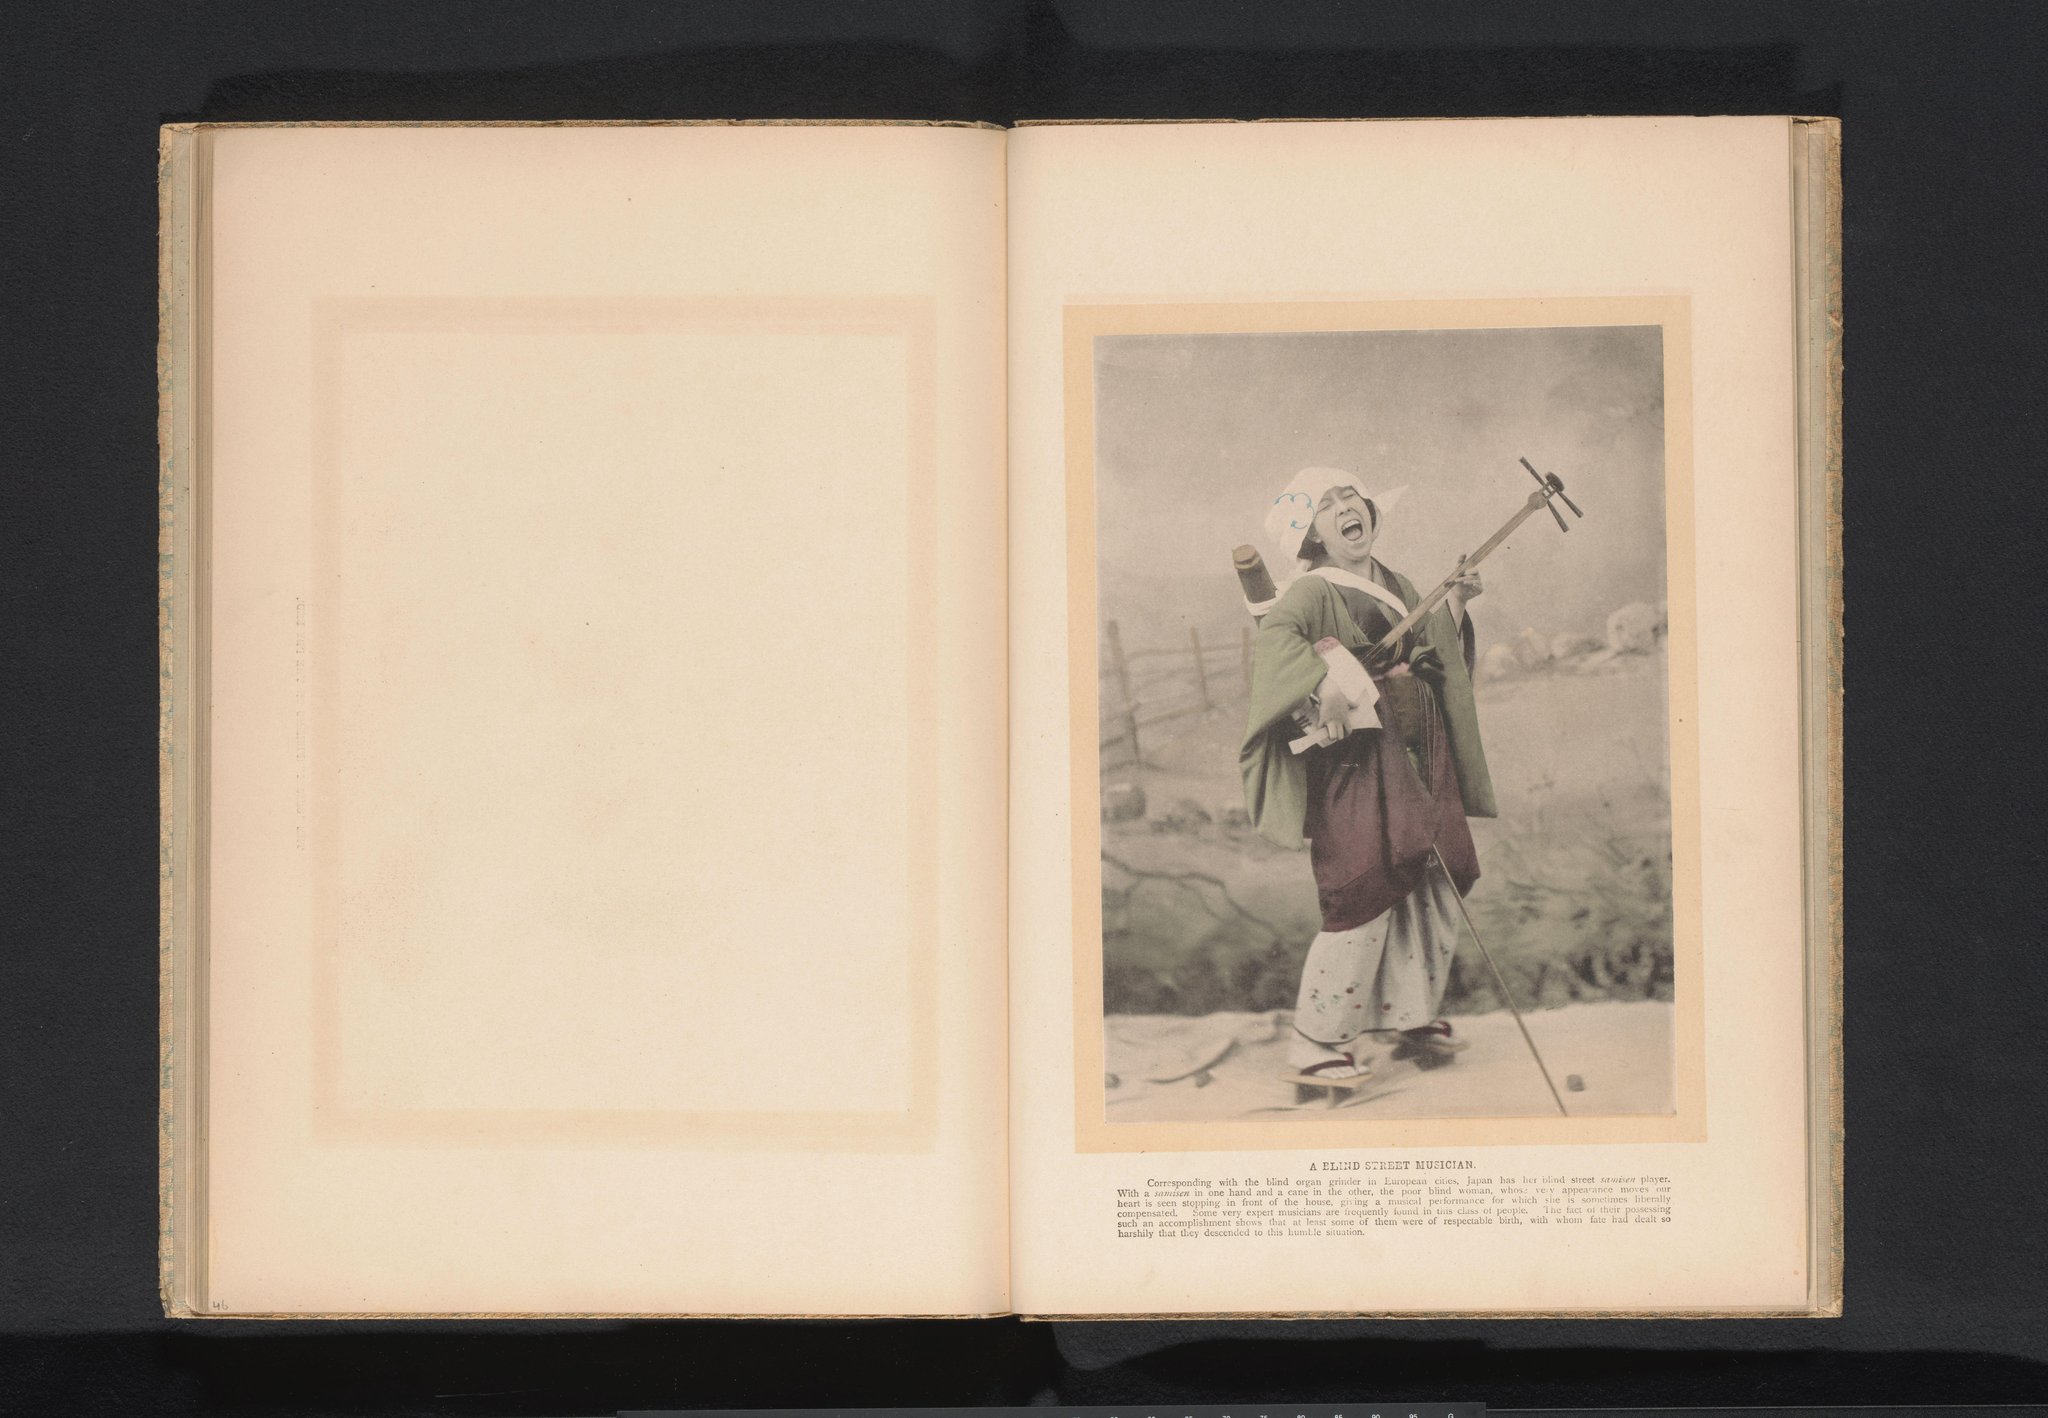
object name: page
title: A Blind Street Musician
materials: paper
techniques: photograph, lithograph, hand coloring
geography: tokyo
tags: female singer, other string instruments (plucked), japan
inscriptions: inscription: ‘Corresponding with (...) humble situation.’